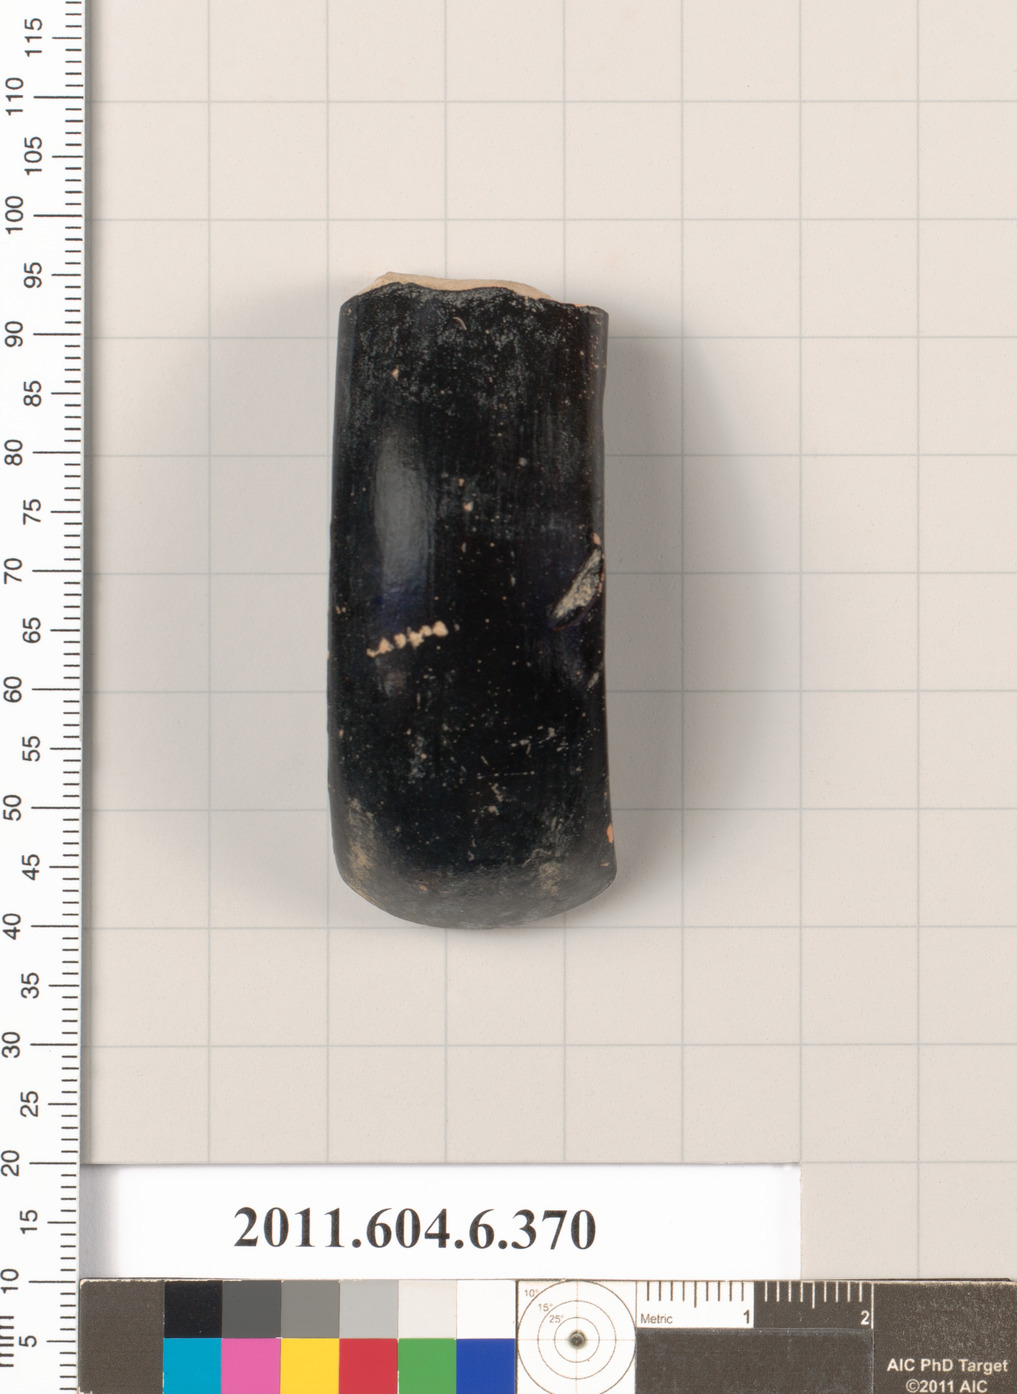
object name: undetermined shape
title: Terracotta fragment of an undetermined shape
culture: greek, attic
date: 600-401 BCE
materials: terracotta